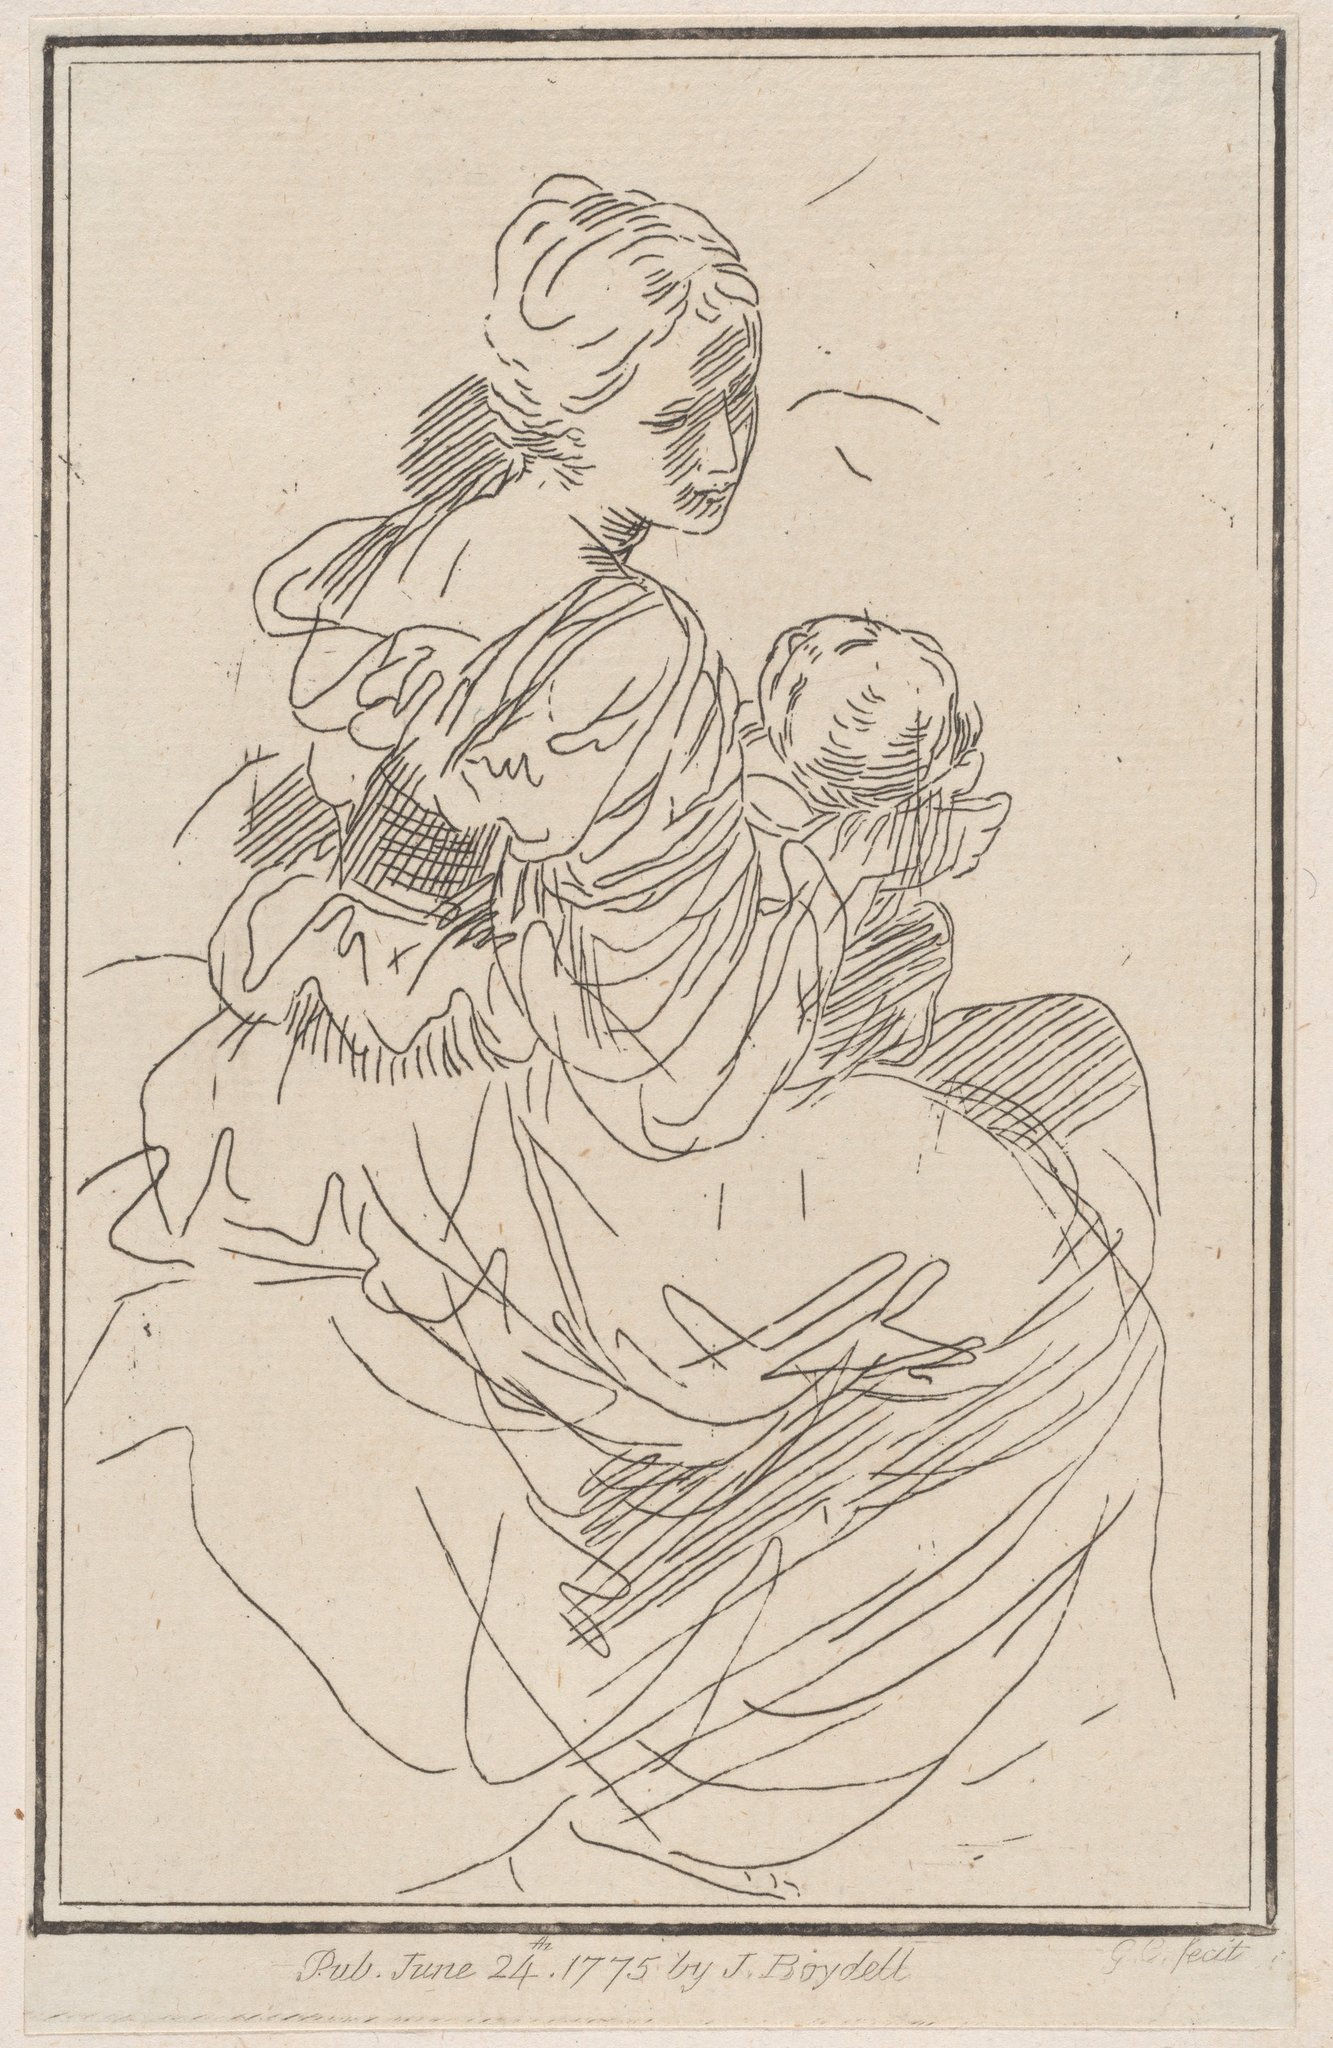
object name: print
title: Madonna and Child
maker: giuseppe canale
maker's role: artist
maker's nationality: italian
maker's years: 1725-1802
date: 1775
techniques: etching